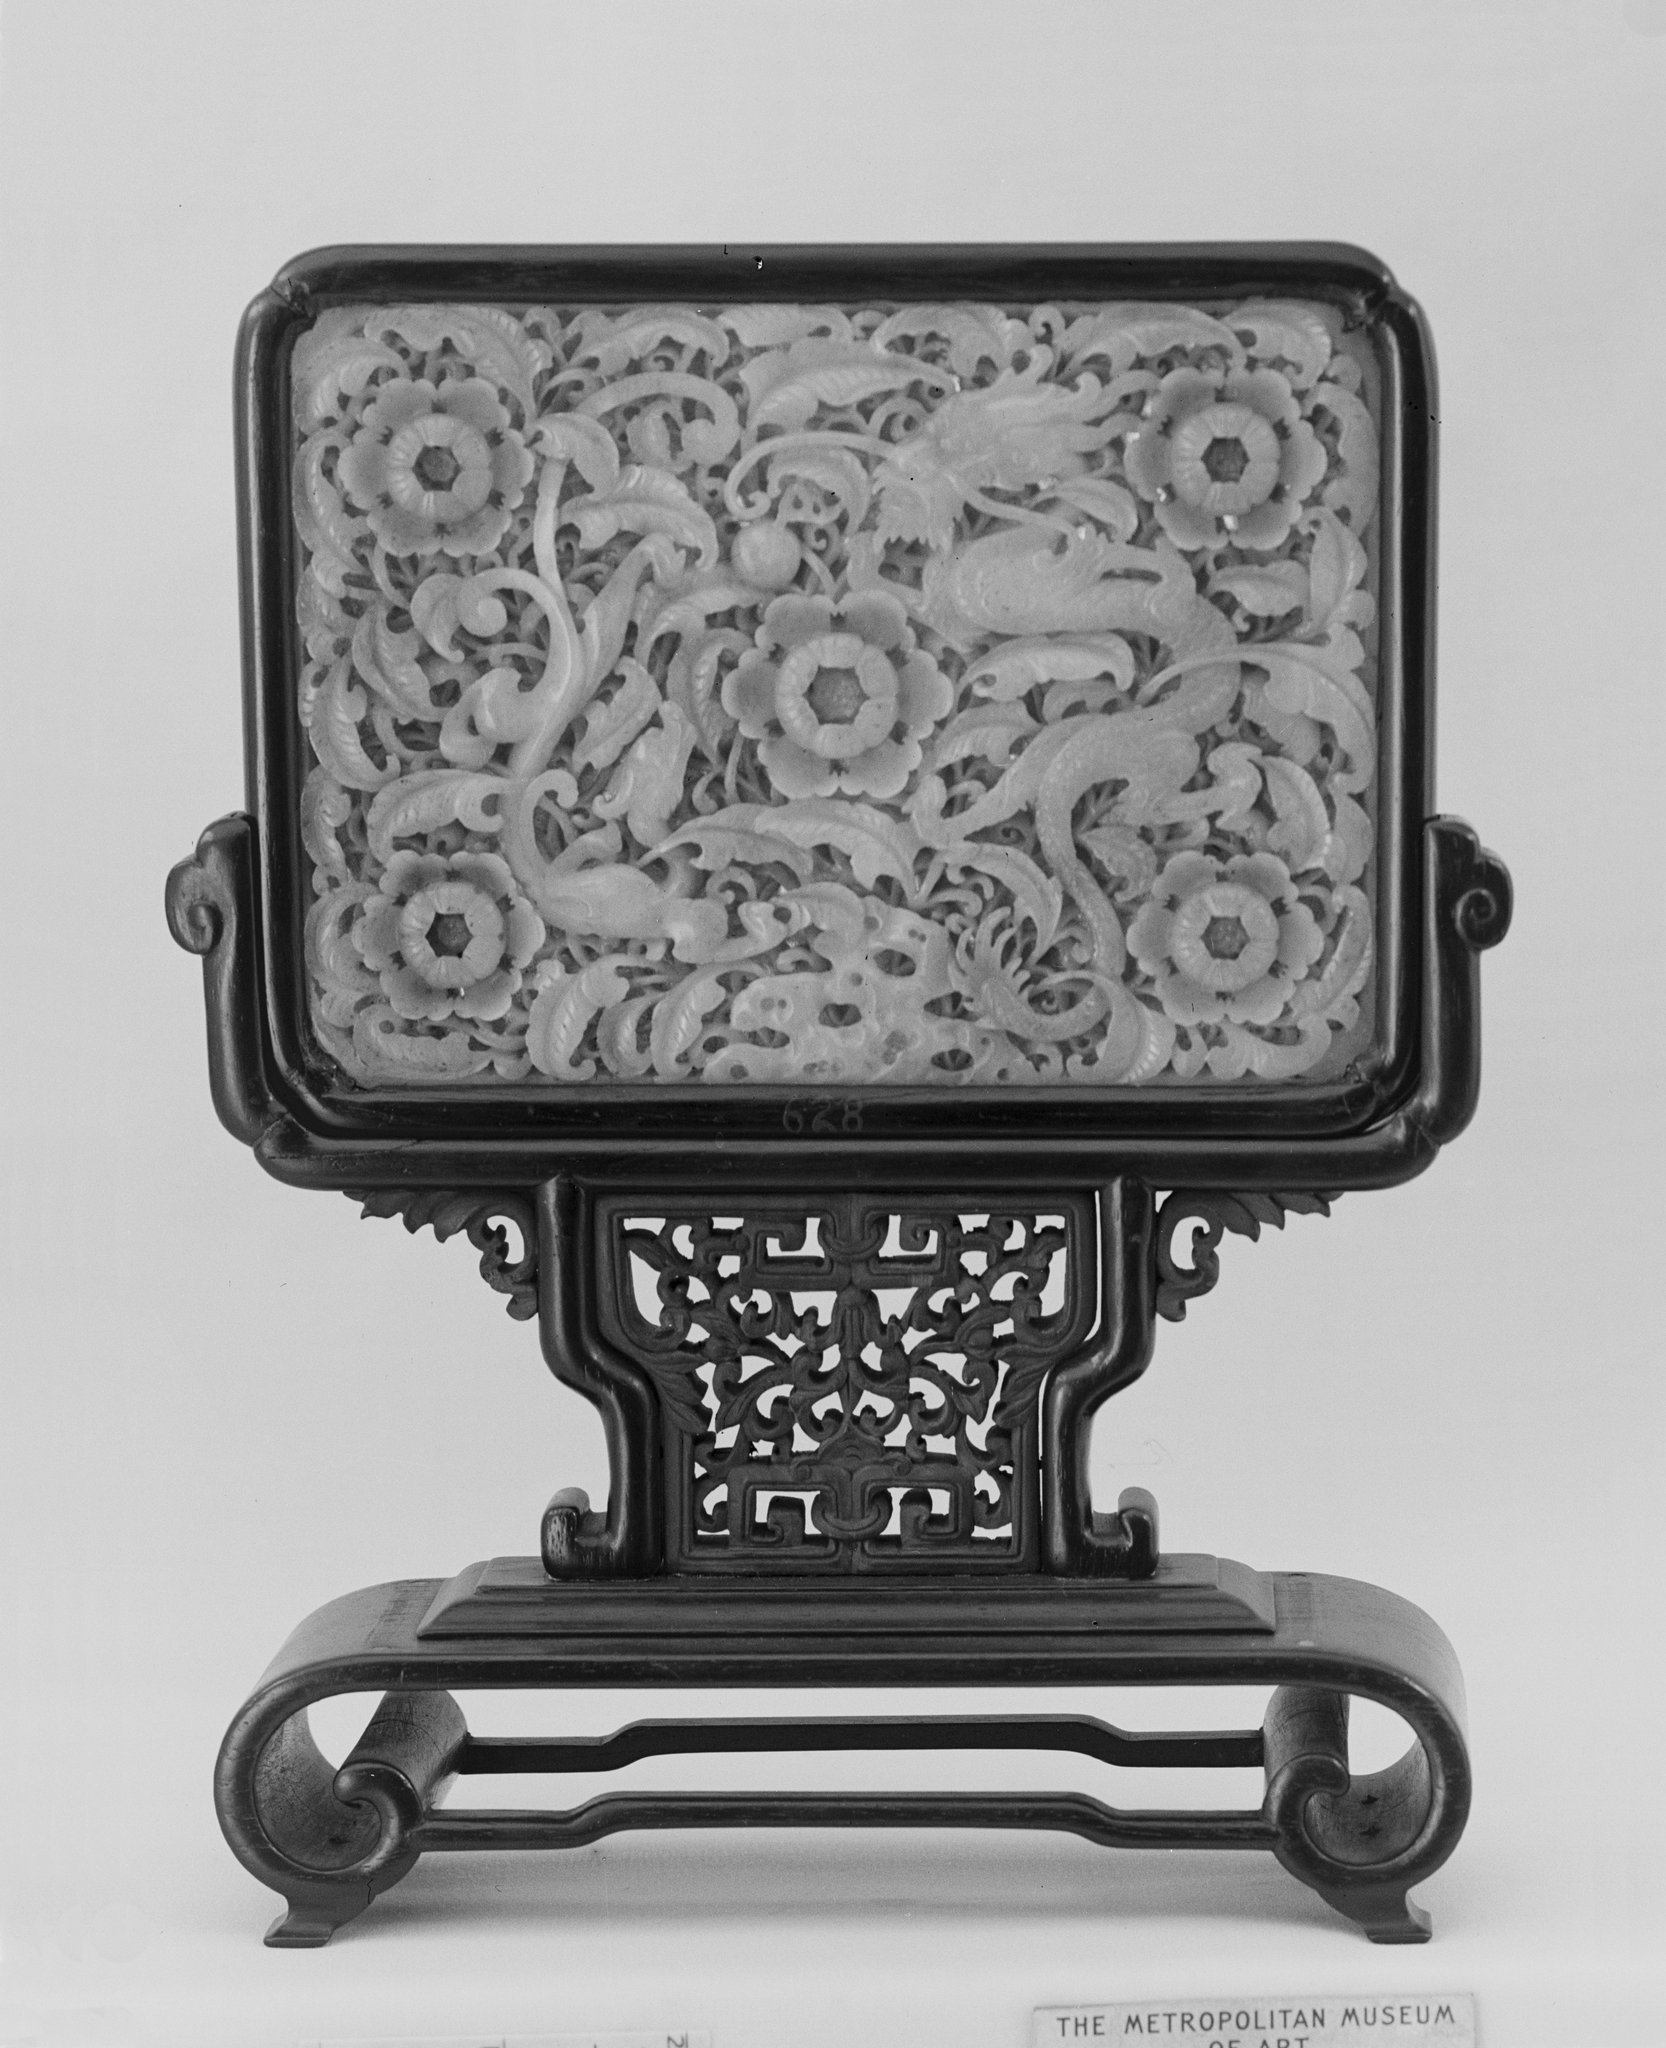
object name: table screen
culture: chinese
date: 1736-1795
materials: jade